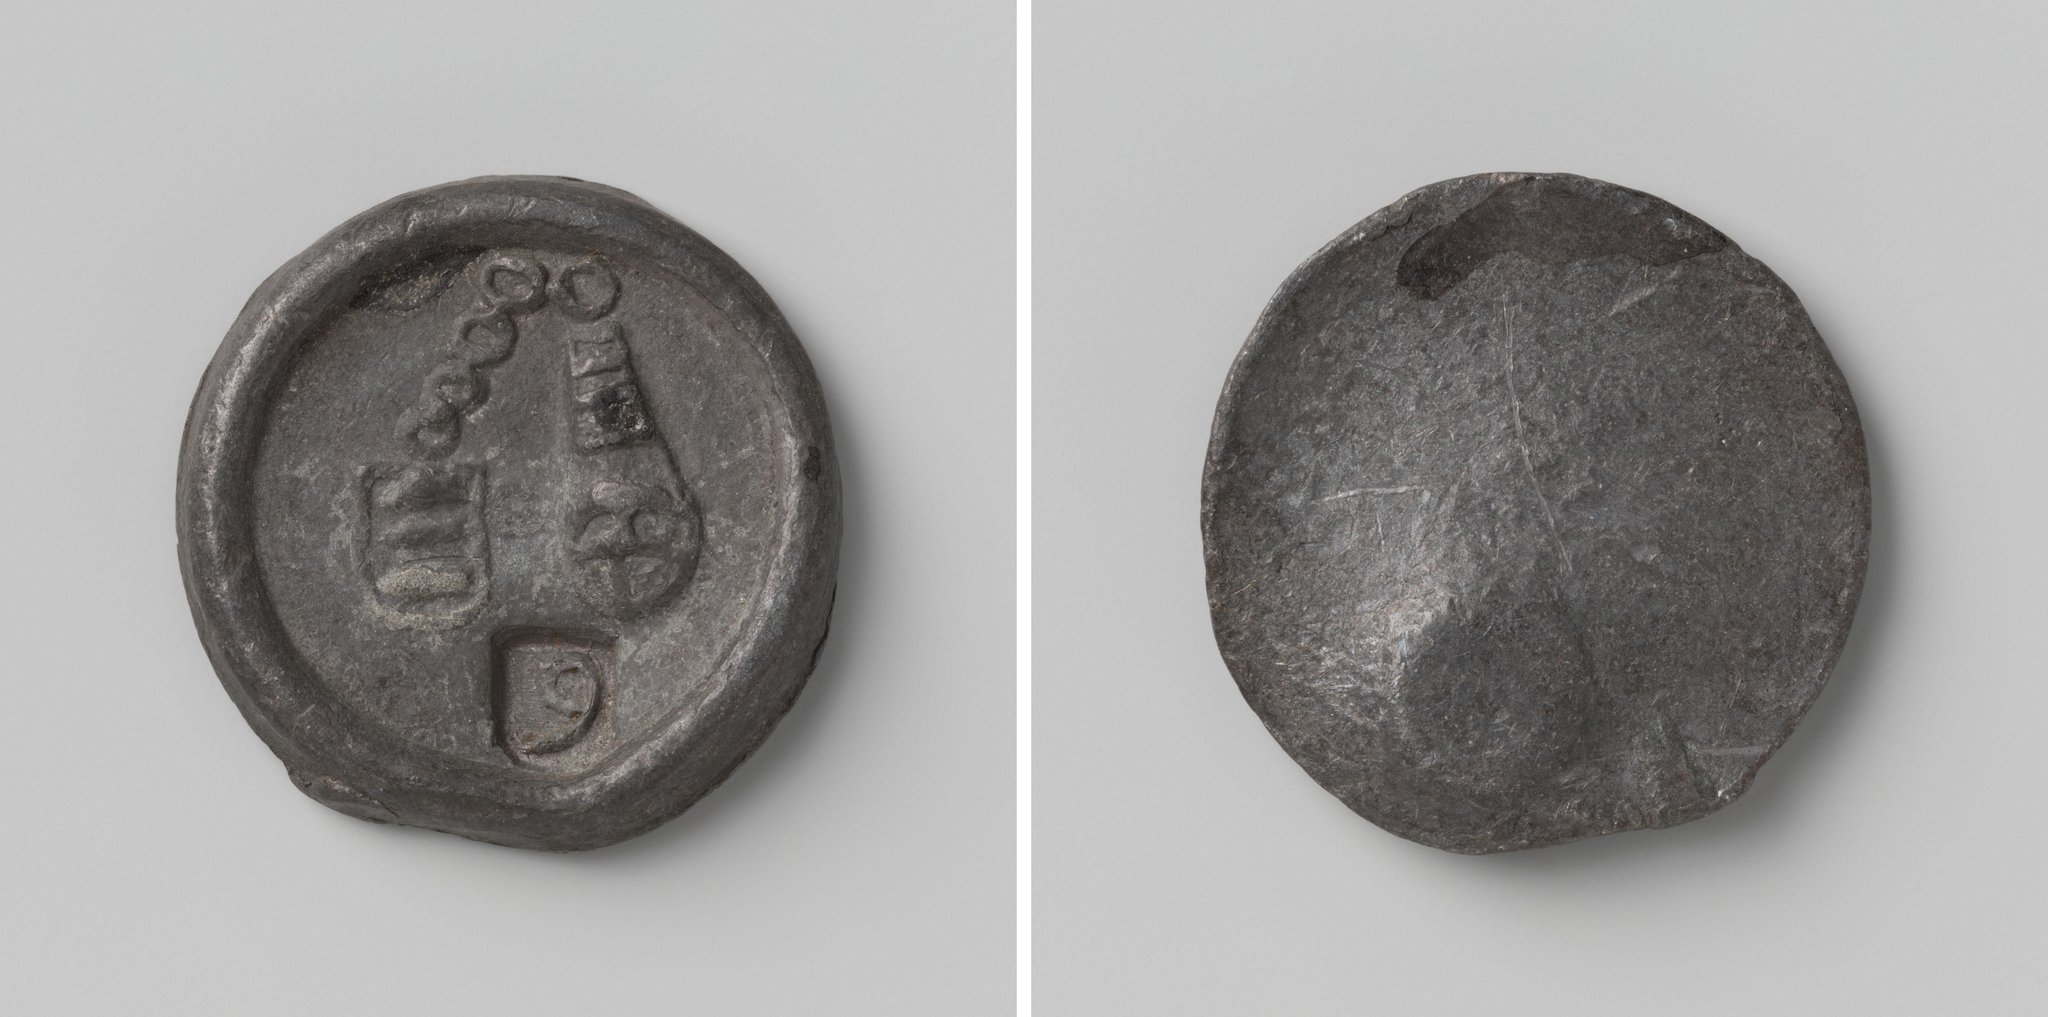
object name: bakenlood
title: Stad Enkhuizen, loodje met cijfer 9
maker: Anonymous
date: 1600-1800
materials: lead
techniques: striking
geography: enkhuizen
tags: enkhuizen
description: eenzijdig loodje. Voorzijde: stempel en wapenschild boven compartiment met cijfer 9. Keerzijde: blanco